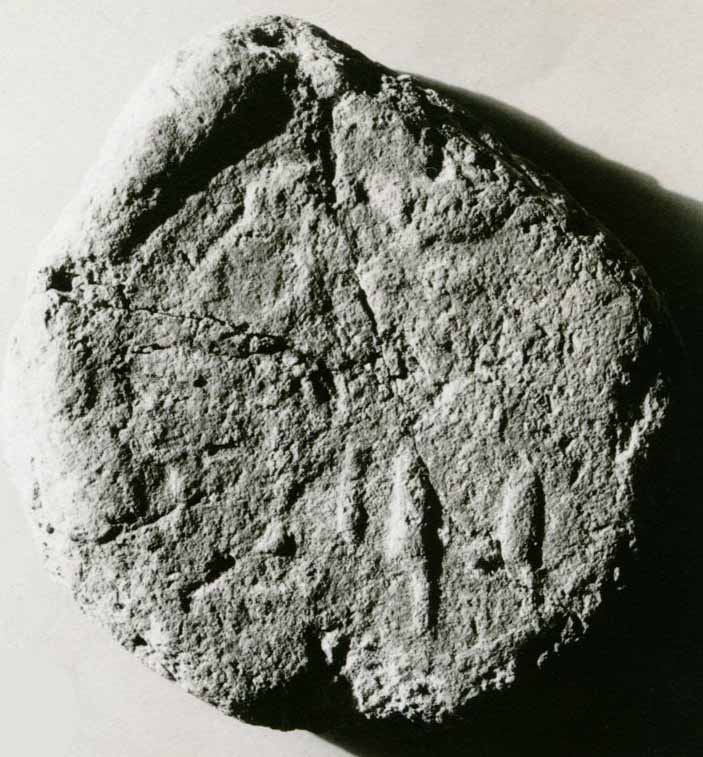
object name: cone, nebseny, circular impression, wab priest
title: Funerary Cone of the Wab-Priest Nebseny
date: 1550-1295 BCE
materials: pottery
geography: egypt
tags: hieroglyphs